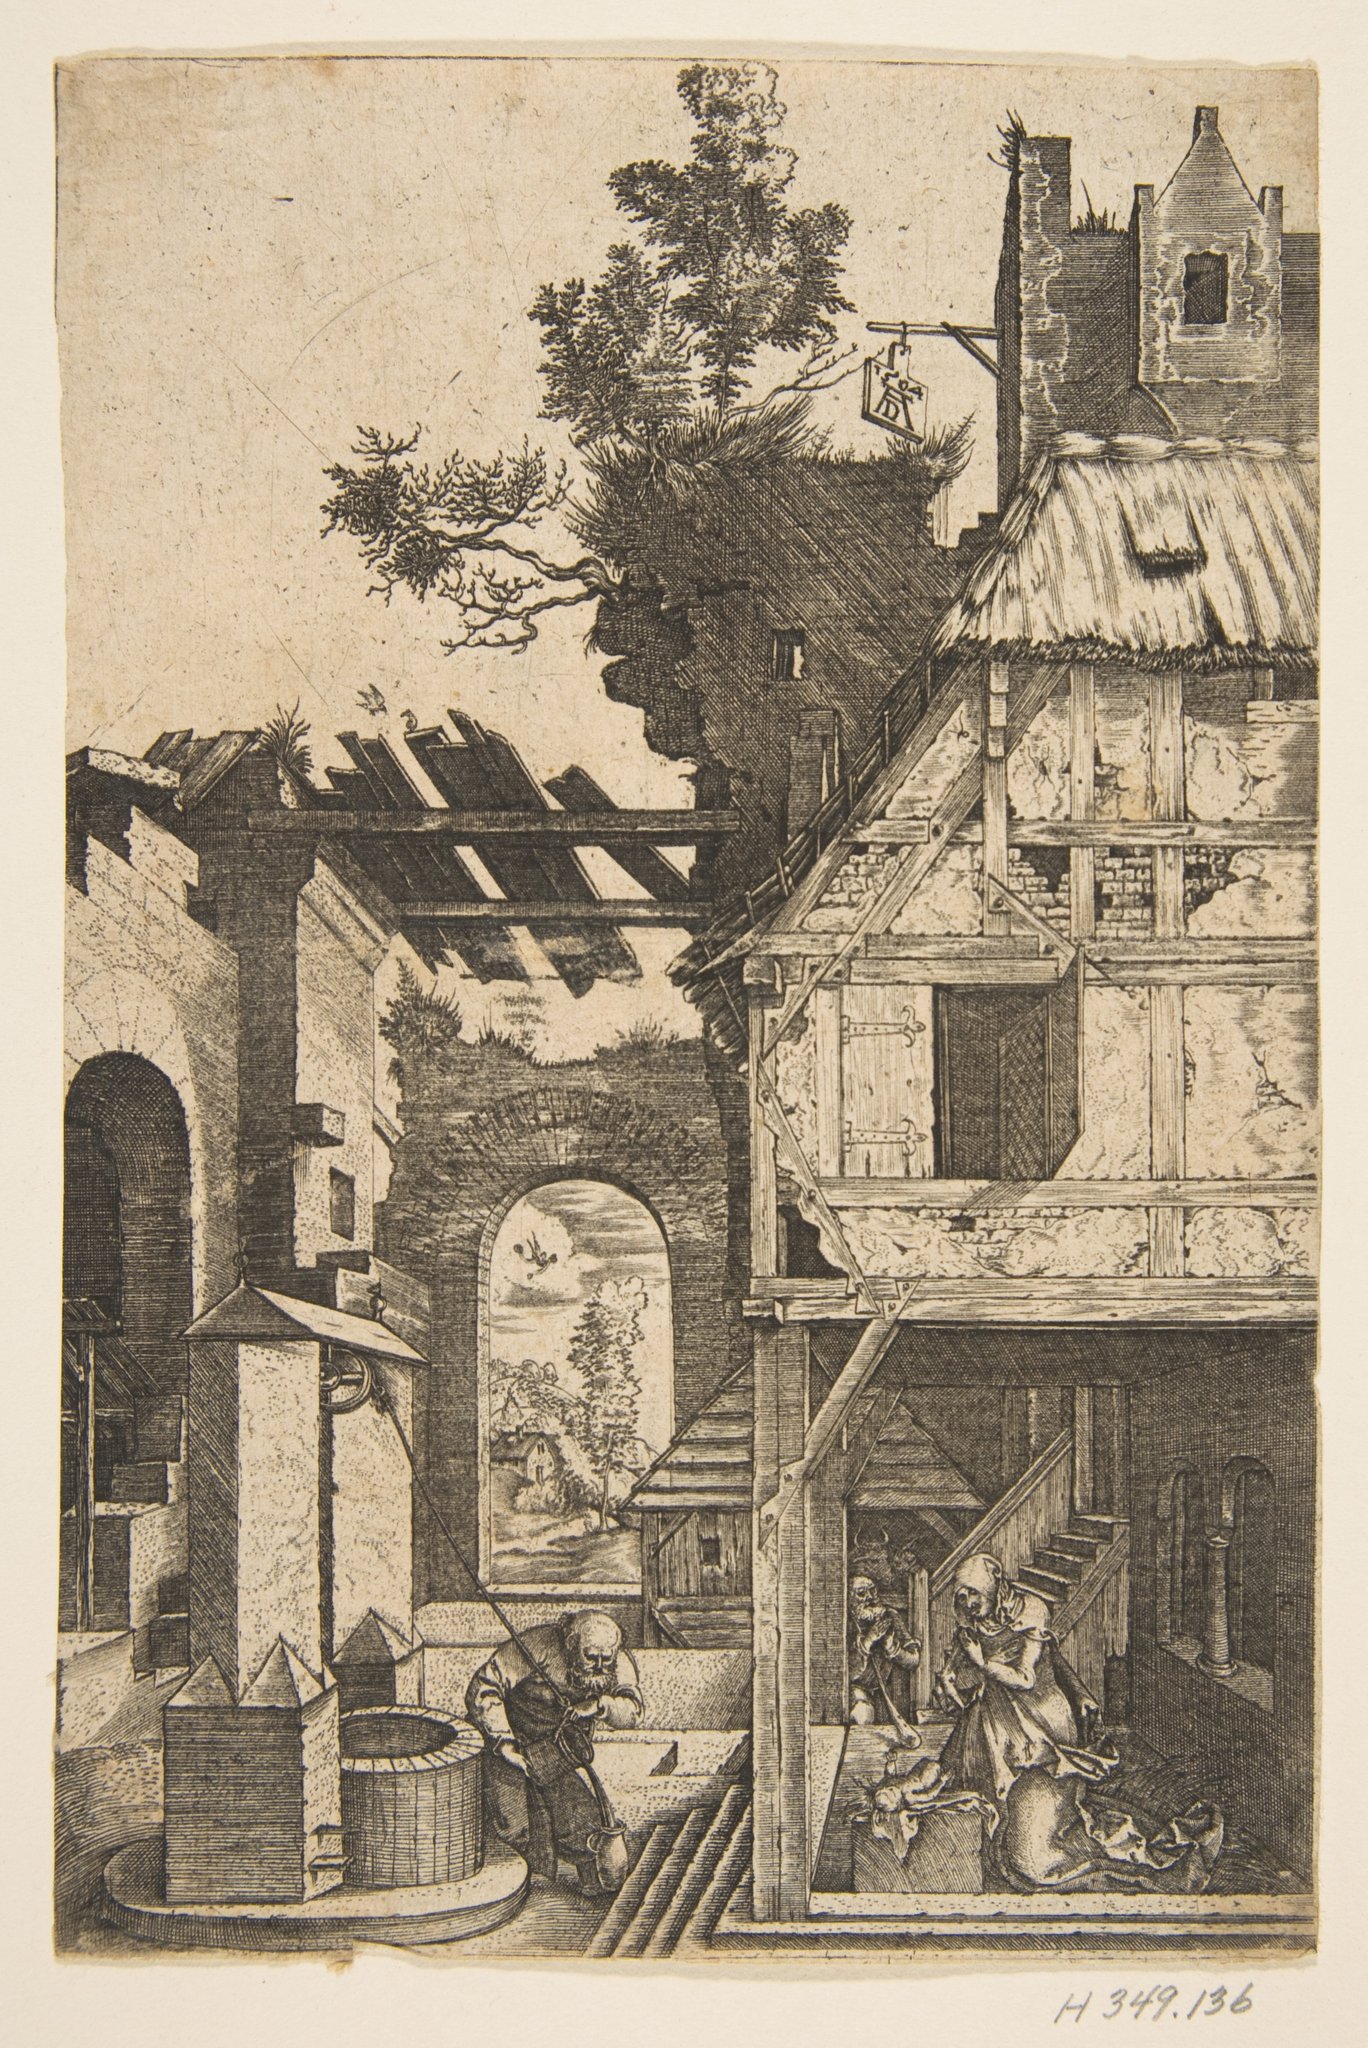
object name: print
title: The Nativity (reverse copy)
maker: albrecht dürer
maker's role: artist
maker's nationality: german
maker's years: 1471-1528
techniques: engraving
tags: men,christ,virgin mary,nativity